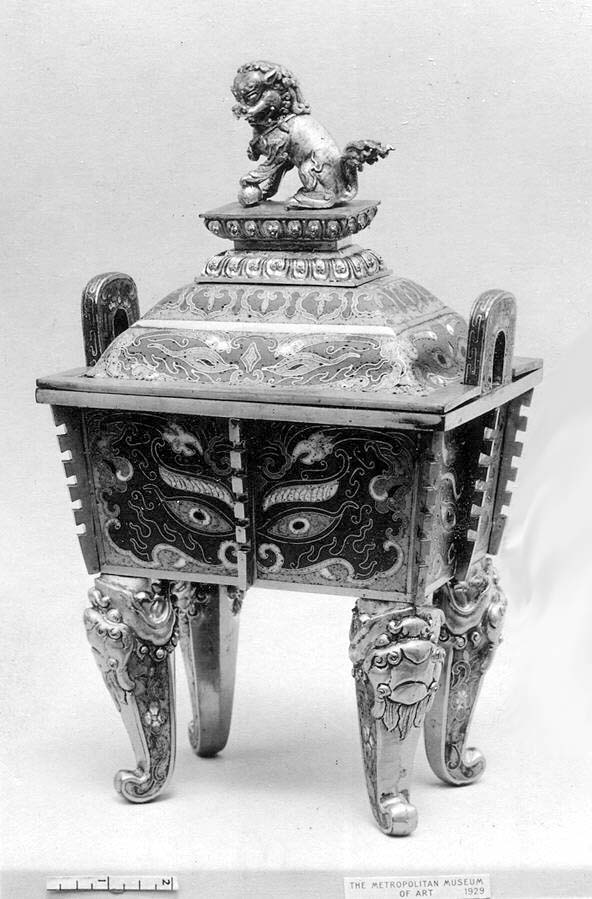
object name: incense burner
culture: chinese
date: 1701-1800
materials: enamel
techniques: enamel, painting